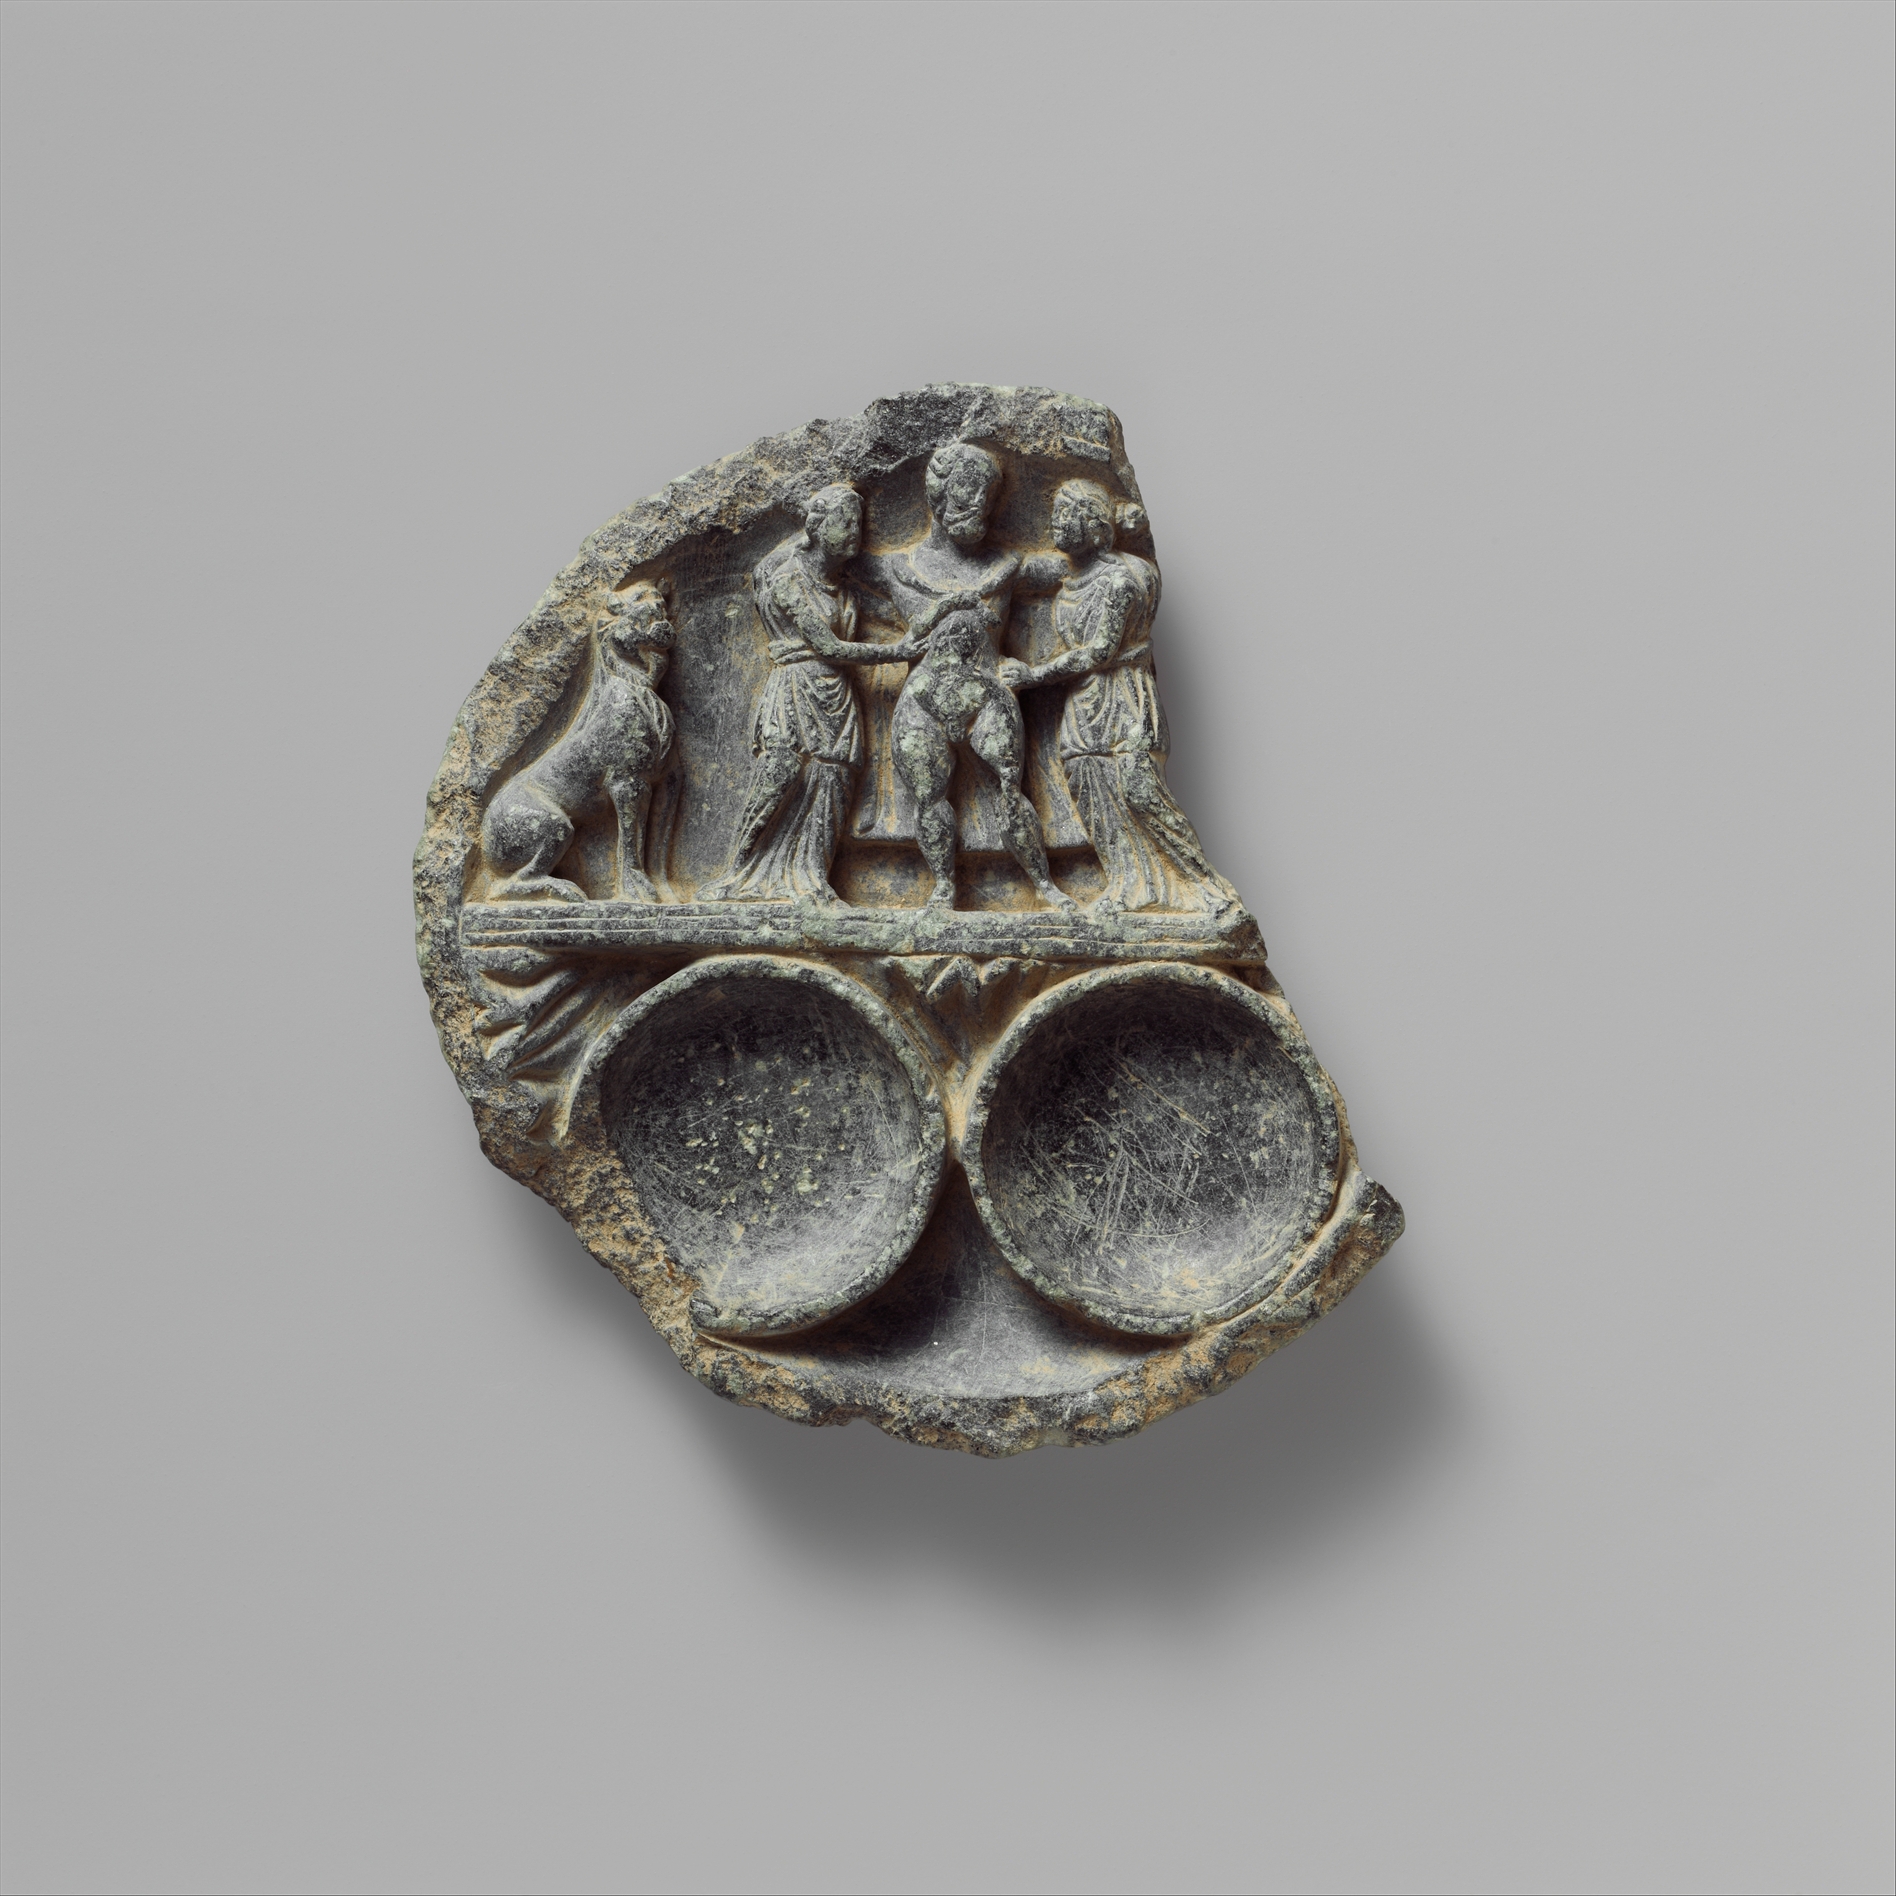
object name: fragment of a dish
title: Dish with the Drunken Hercules Supported by Two Women and Flanked by a Lion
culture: gandhara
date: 1-100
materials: stone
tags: gandhara,women,lions,herakles